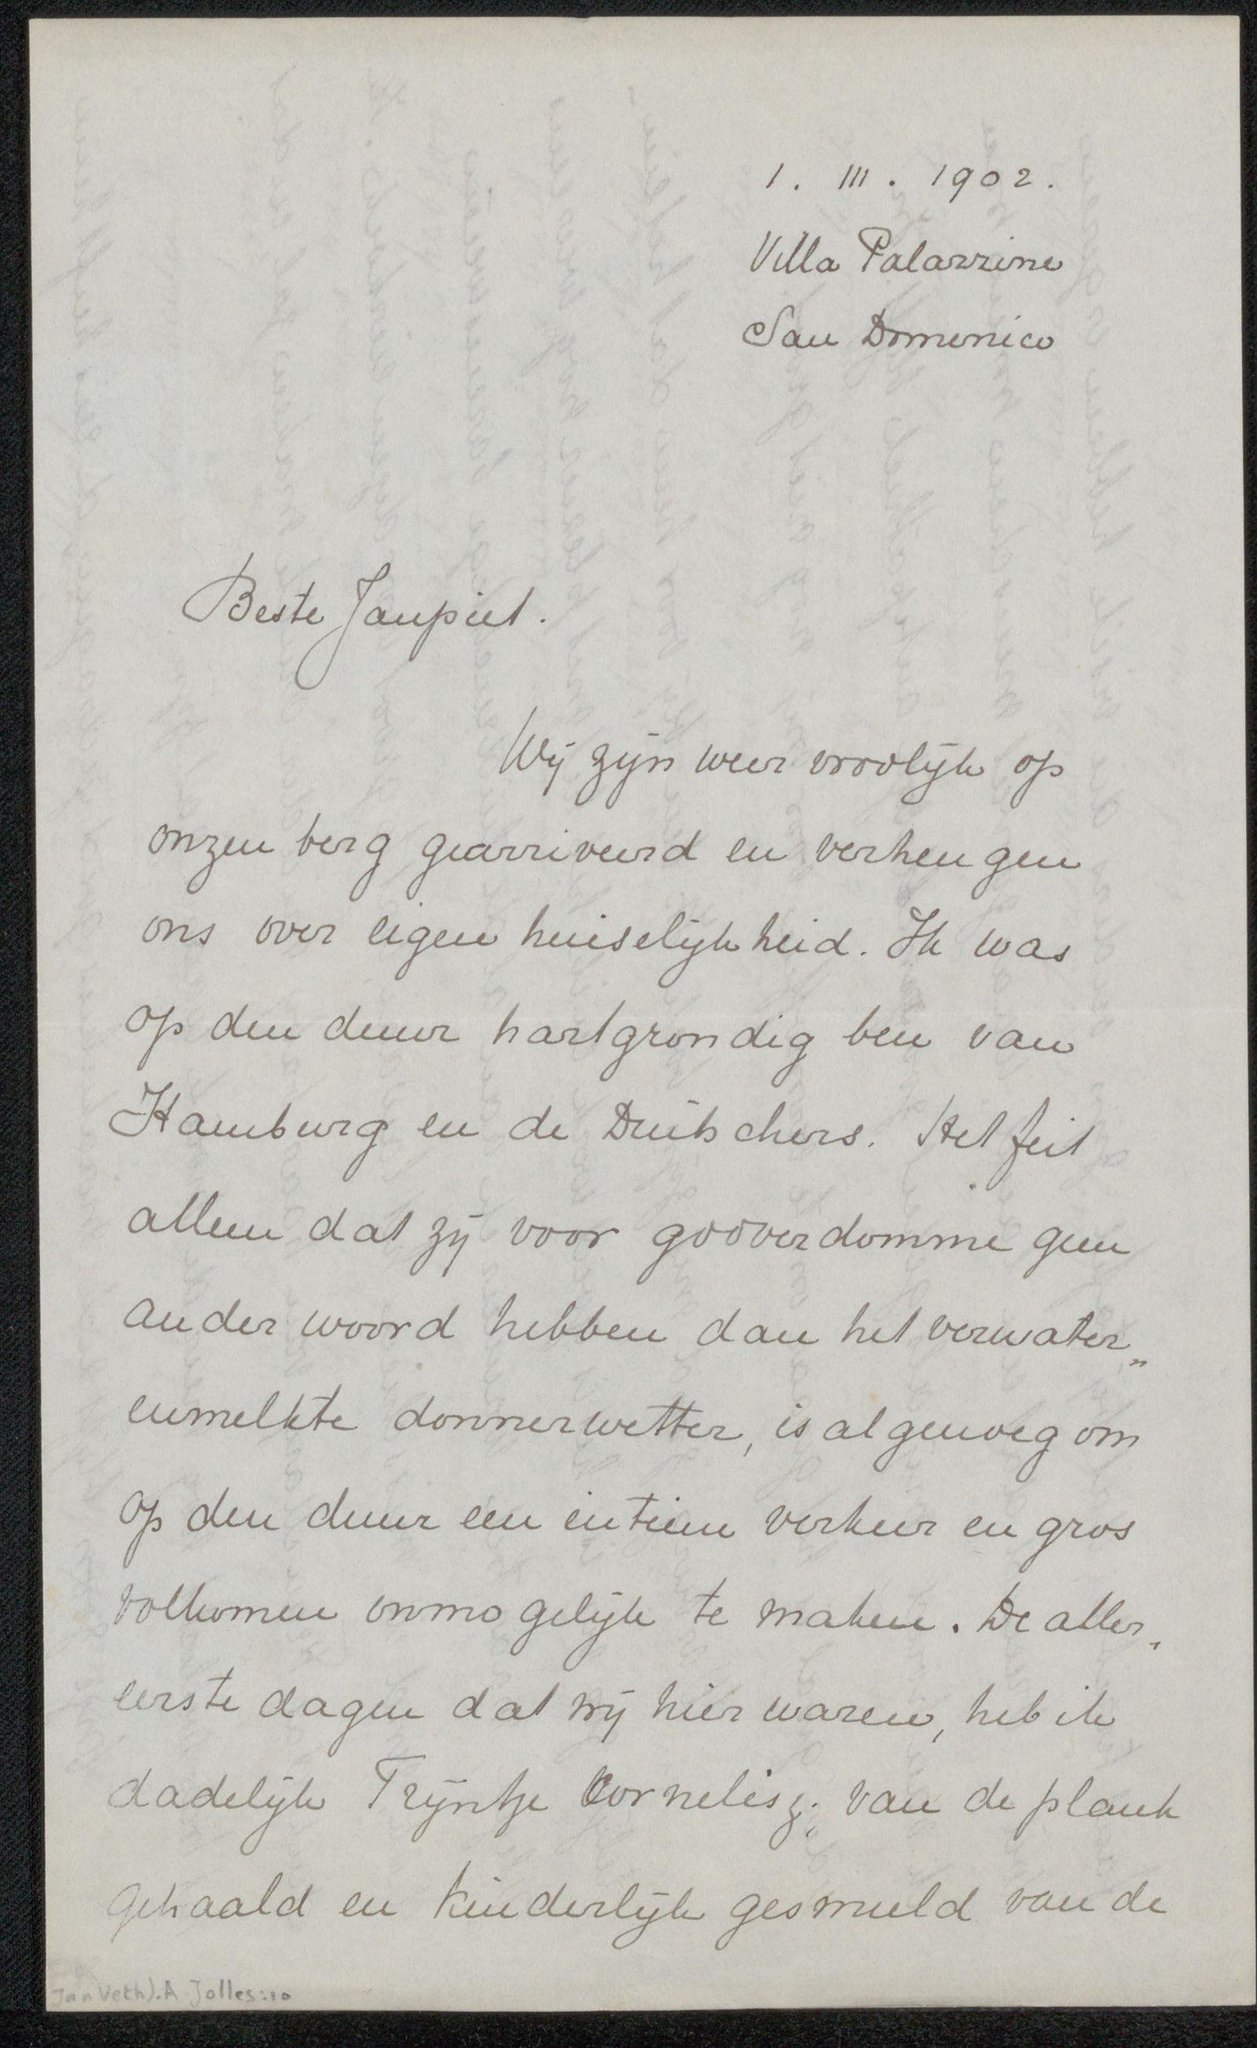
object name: letter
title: Brief aan Jan Veth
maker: andré jolles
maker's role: journalist, kunsthistoricus, letterkundige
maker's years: 1874-1946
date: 1902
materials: ink, paper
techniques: pen, writing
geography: san domenico da fiesole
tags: dordrecht, amsterdam, painter, print maker, draughtsman, designer, jan veth, constantijn huygens (i), politician, pieter lodewijk tak, aby warburg, sculptor, passions, emotions, affections, literature ~ arts, germany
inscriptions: watermark, collector's mark: ‘RPK’